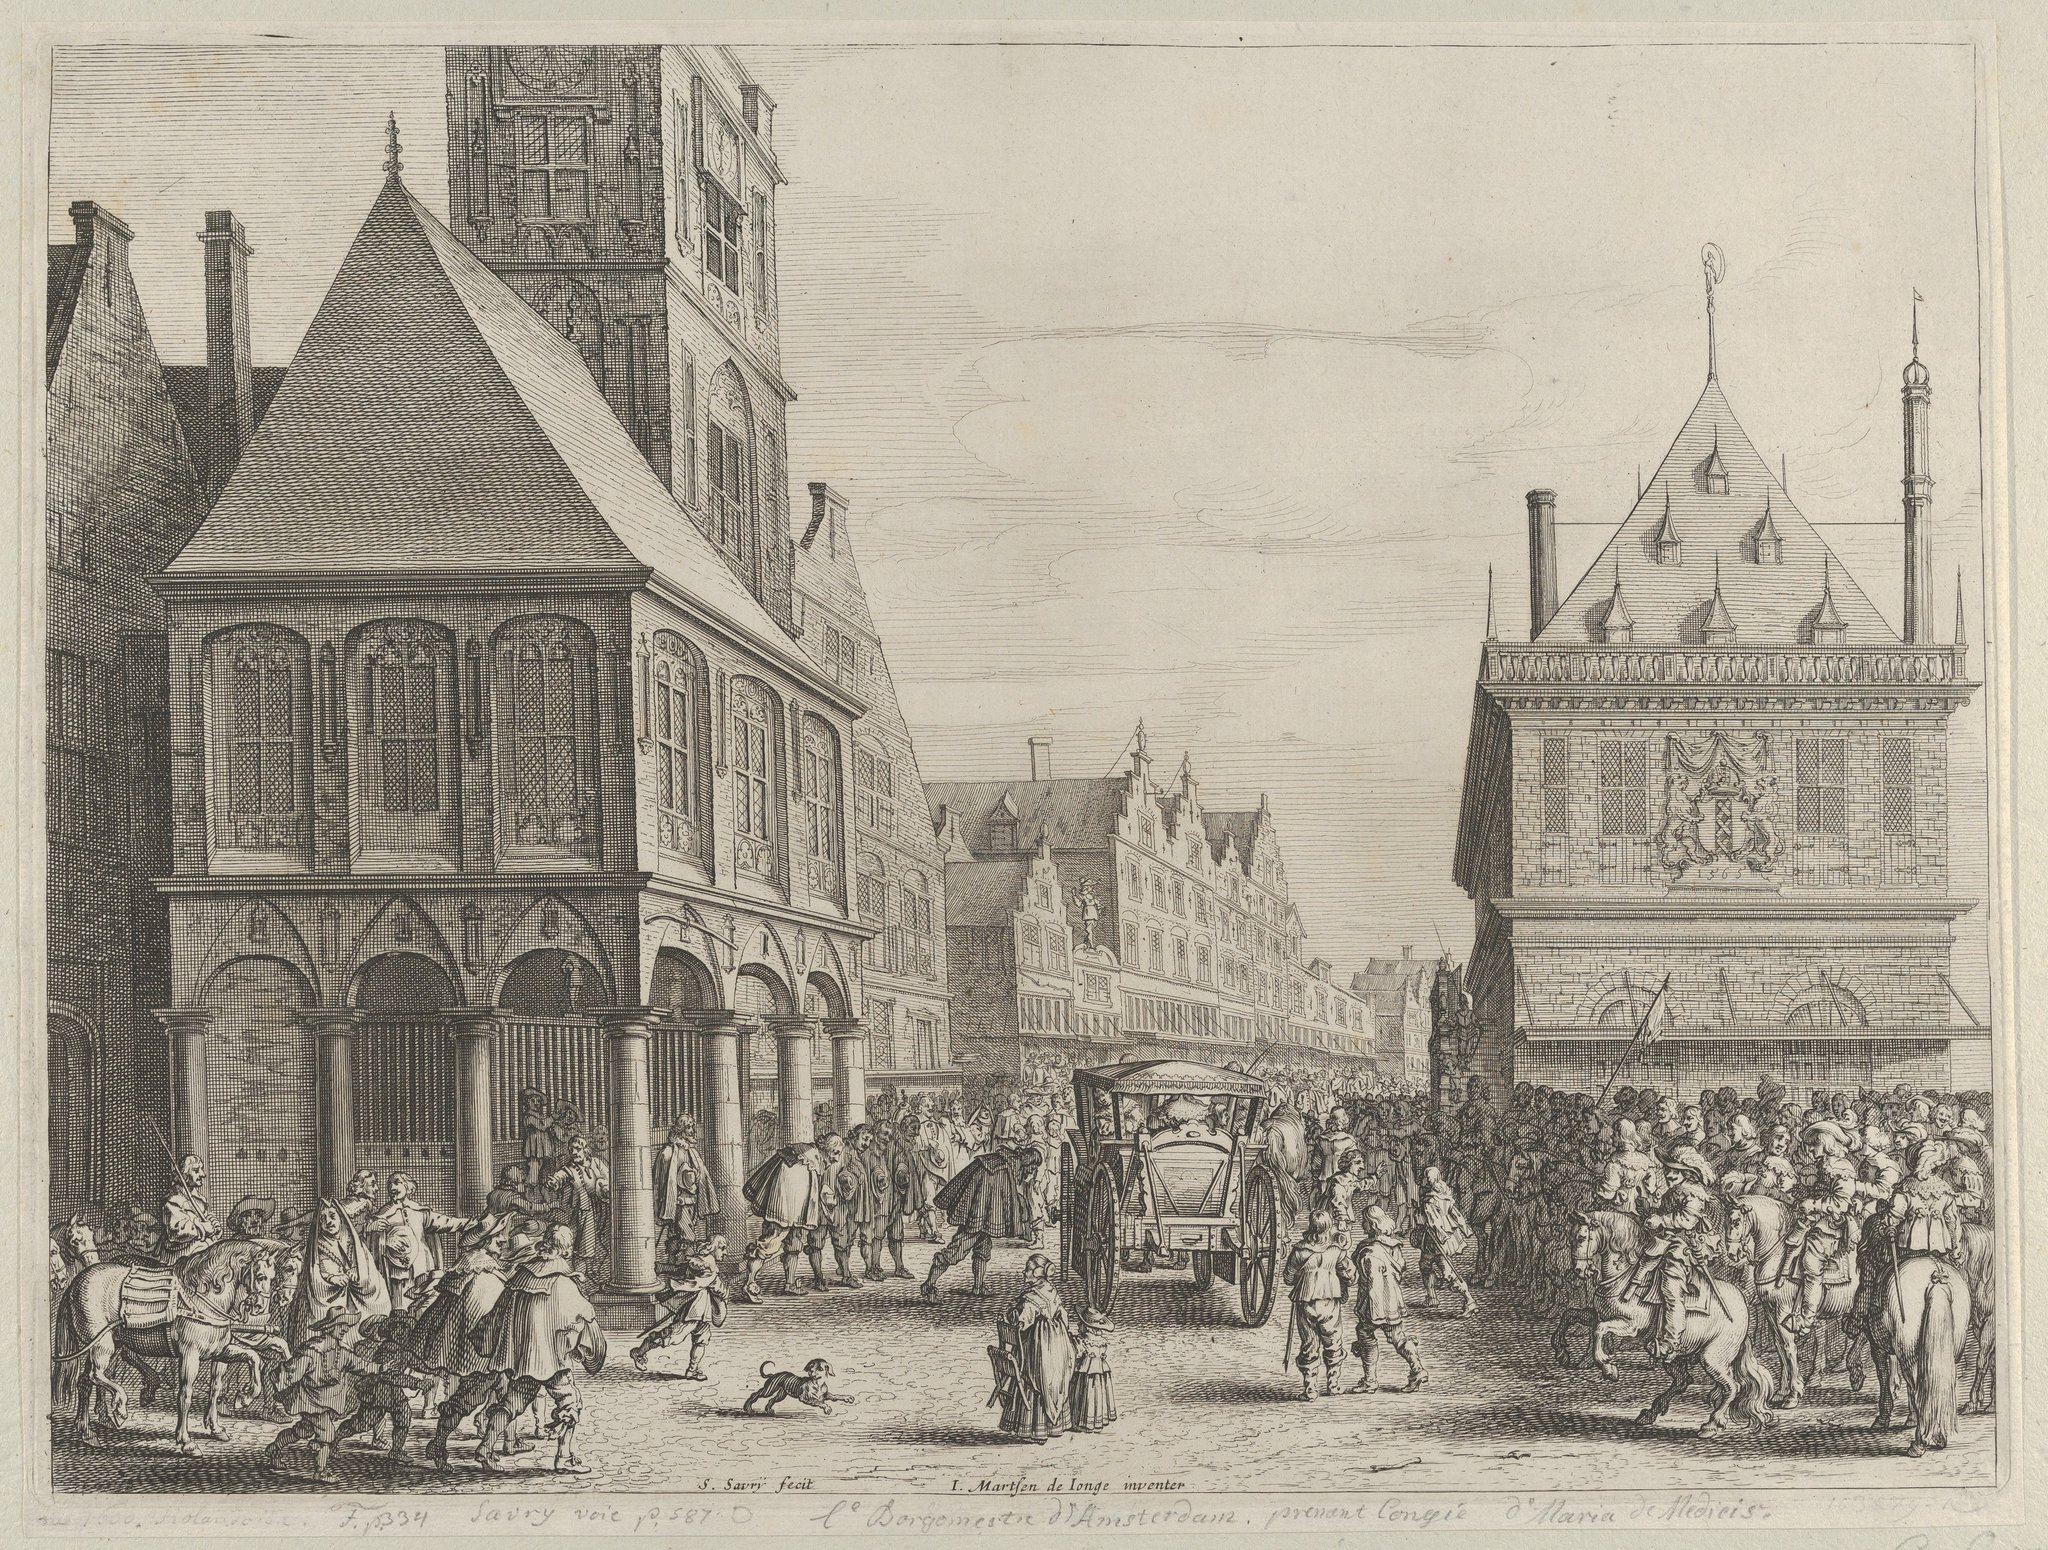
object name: print, fete, ornament architecture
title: City magistrates taking leave of Marie de Medici before the town hall, from Caspar Barlaeus, "Medicea Hospes"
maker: salomon savery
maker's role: artist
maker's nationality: dutch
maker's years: 1594-1678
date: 1638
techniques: etching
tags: buildings,horses,crowd,carriages